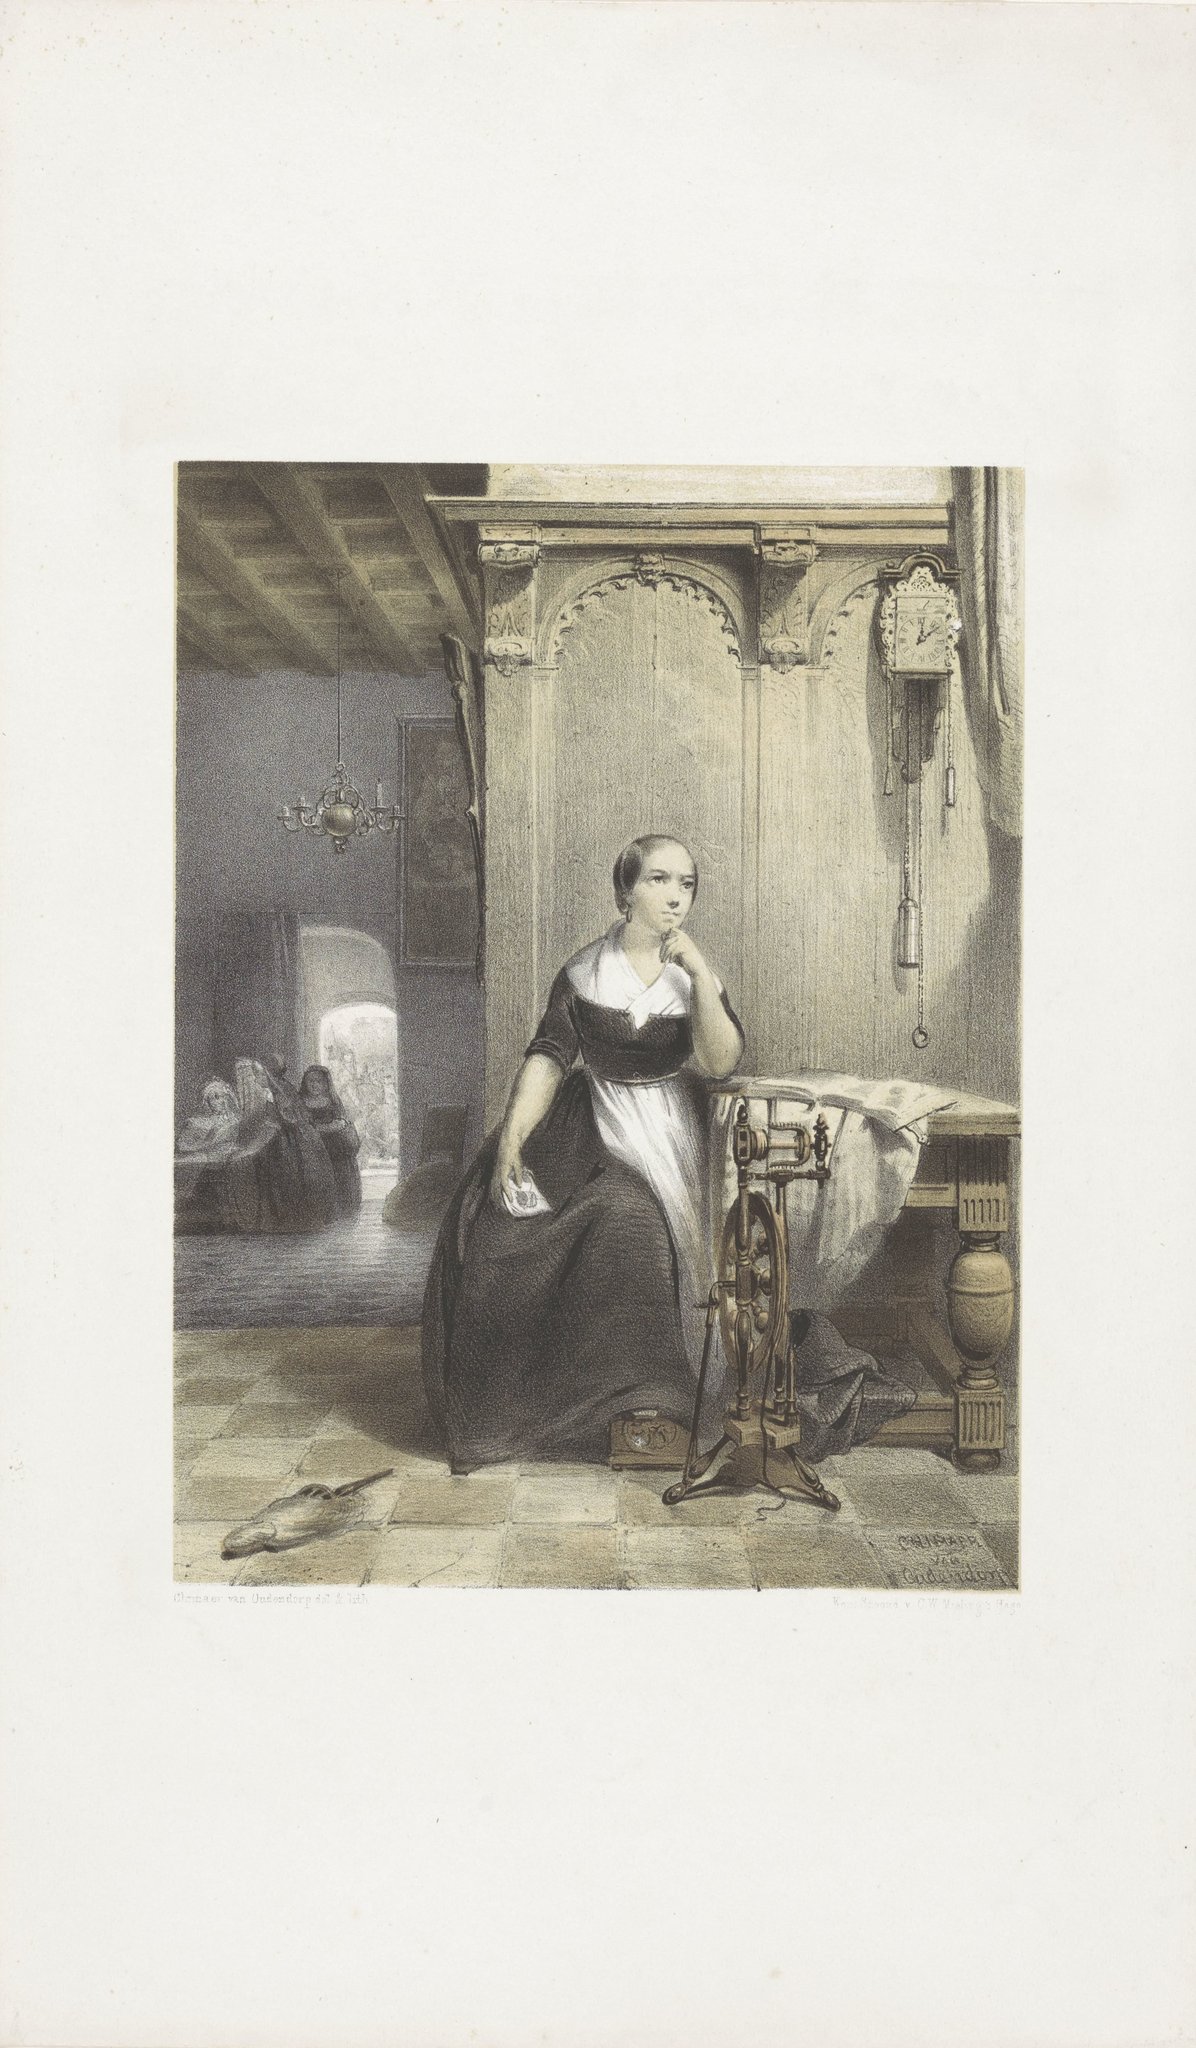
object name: print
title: Peinzend meisje bij spinnewiel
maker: wilhelmus cornelis chimaer van oudendorp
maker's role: print maker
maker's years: 1822-1873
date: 1832-1873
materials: paper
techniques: tone lithography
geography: netherlands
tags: thinking, thought, reflection; 'pensiero' (ripa), spinning-wheel, letter, envelope, looking upwards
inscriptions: collector's mark: Lugt 2228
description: Het meisje kijkt naar rechts en heeft haar linkerhand bij haar gezicht. In haar andere hand heeft zij een brief. Voor haar staat een spinnewiel en aan de wand hangt een klok. In de kamer achter haar zitten drie oudere vrouwen.